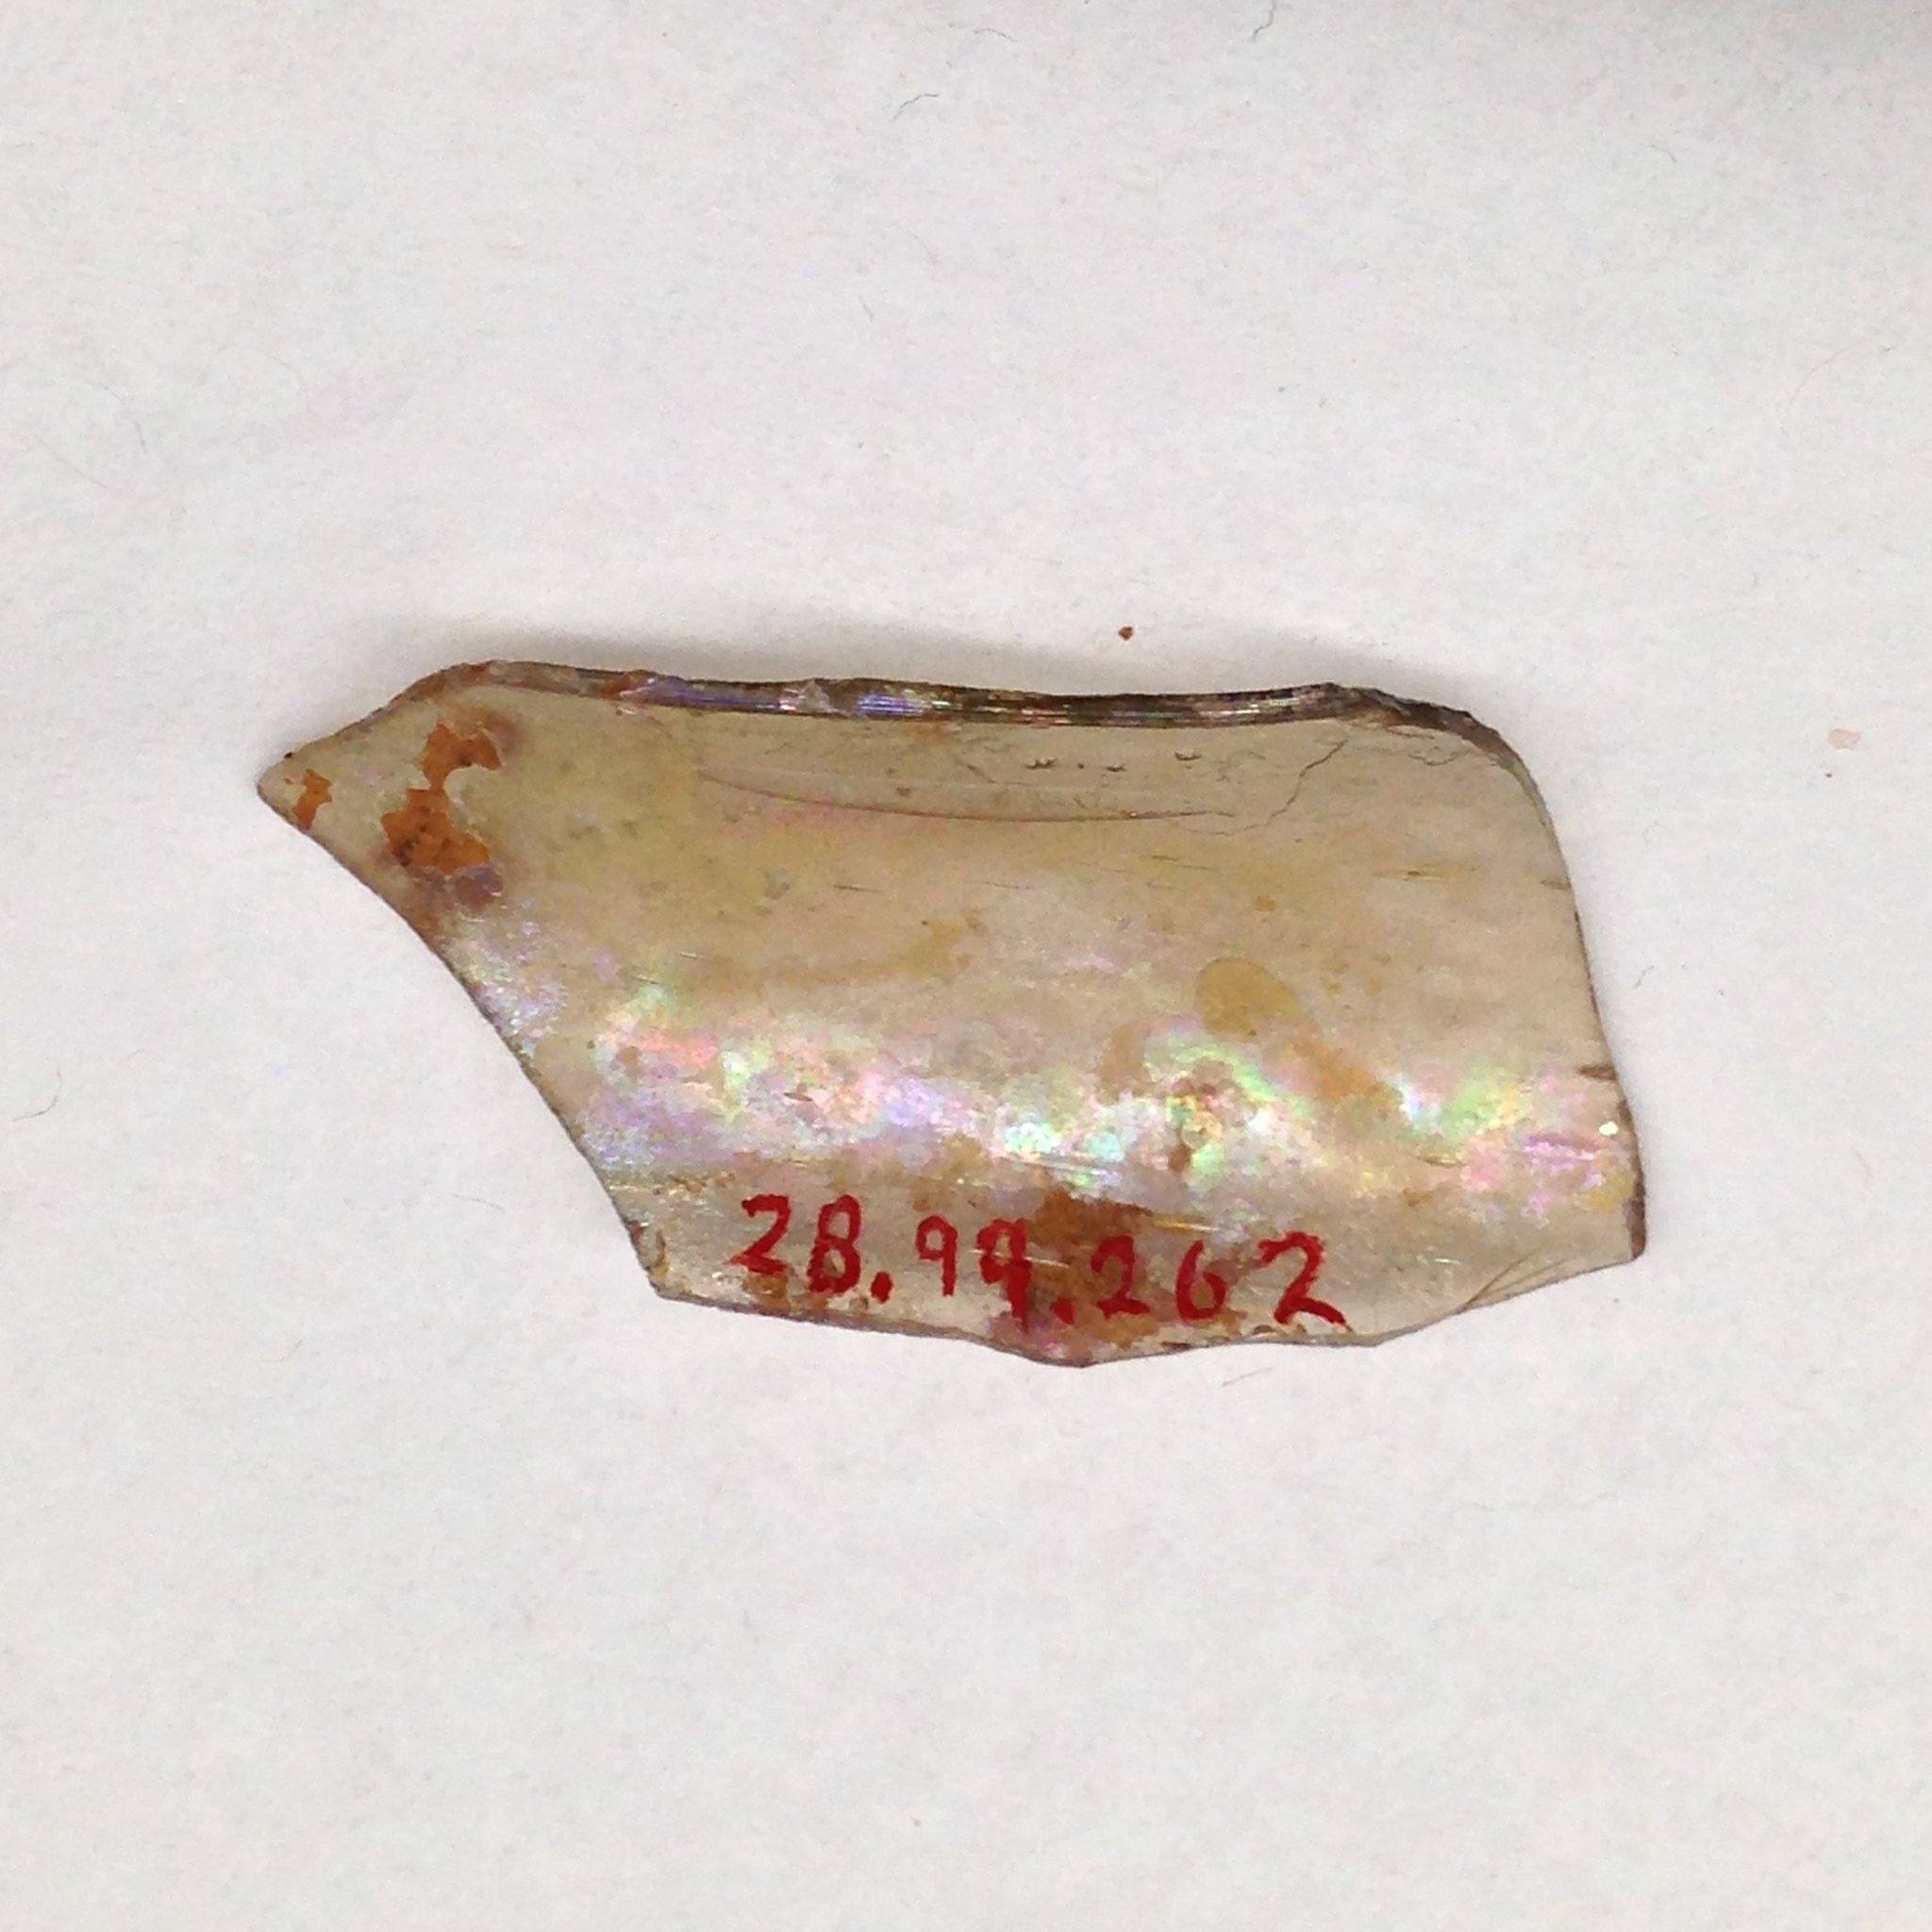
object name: fragment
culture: european or middle eastern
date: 1150-1250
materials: ceramic, glass